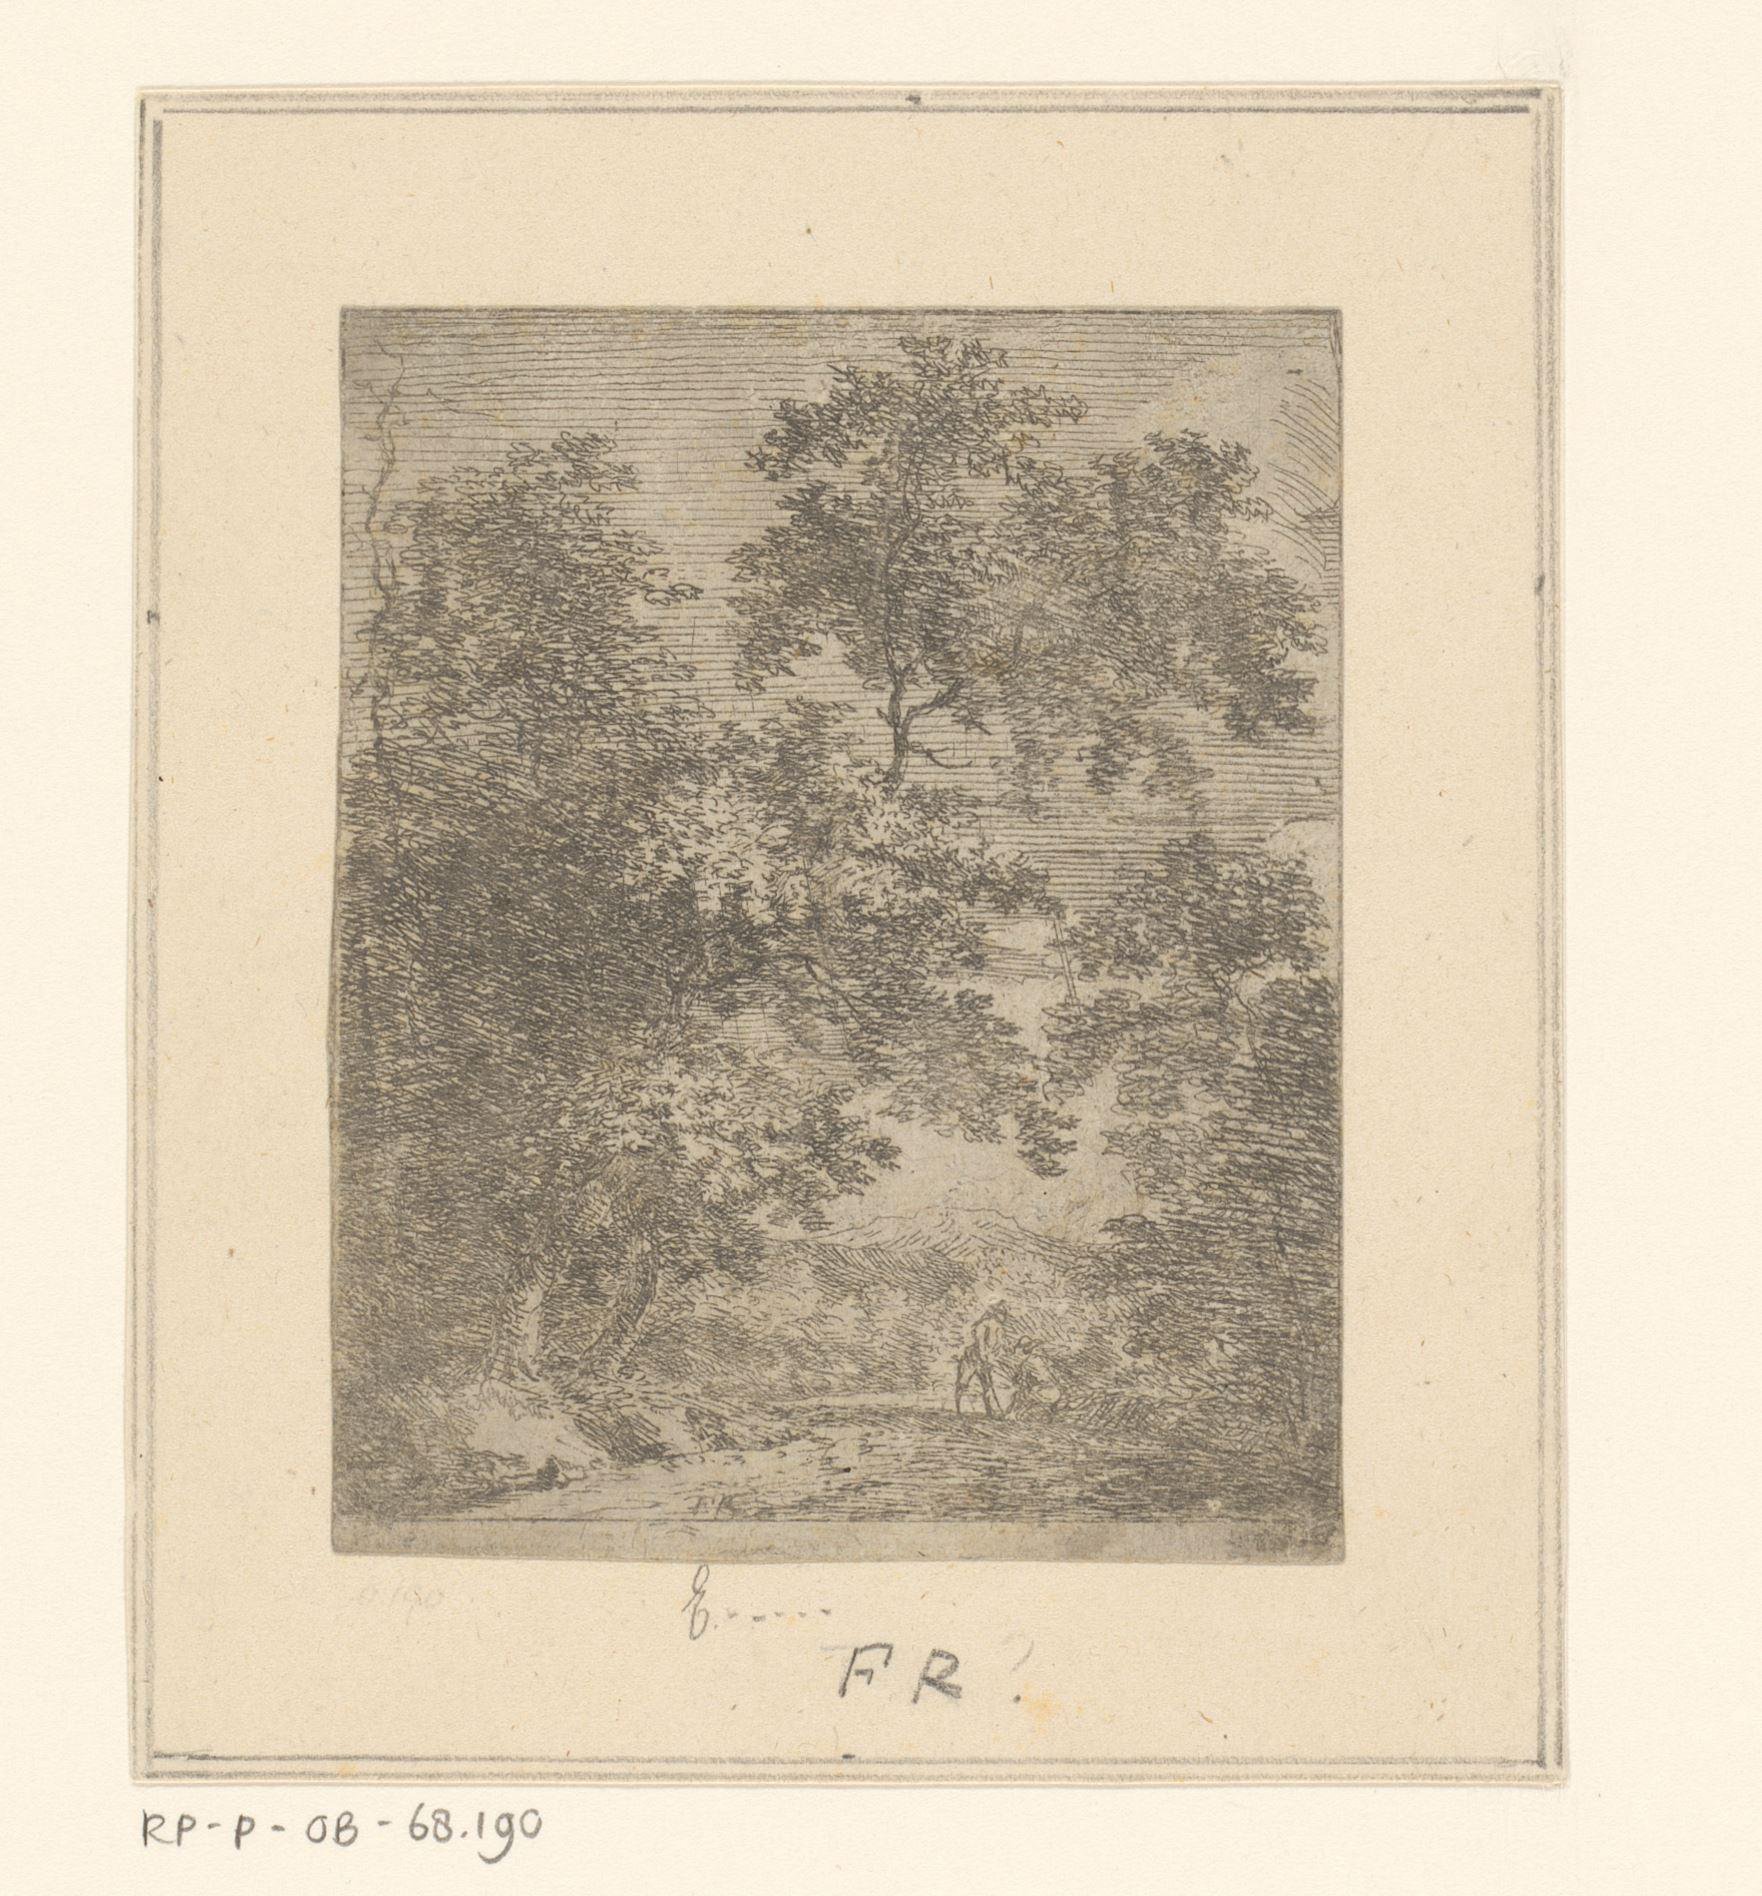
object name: print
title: Twee figuren langs een bospad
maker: monogrammist fr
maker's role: print maker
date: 1700-1799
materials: paper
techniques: etching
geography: northern netherlands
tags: forest path or lane (+ landscape with figures, staffage)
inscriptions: collector's mark: Lugt 2228